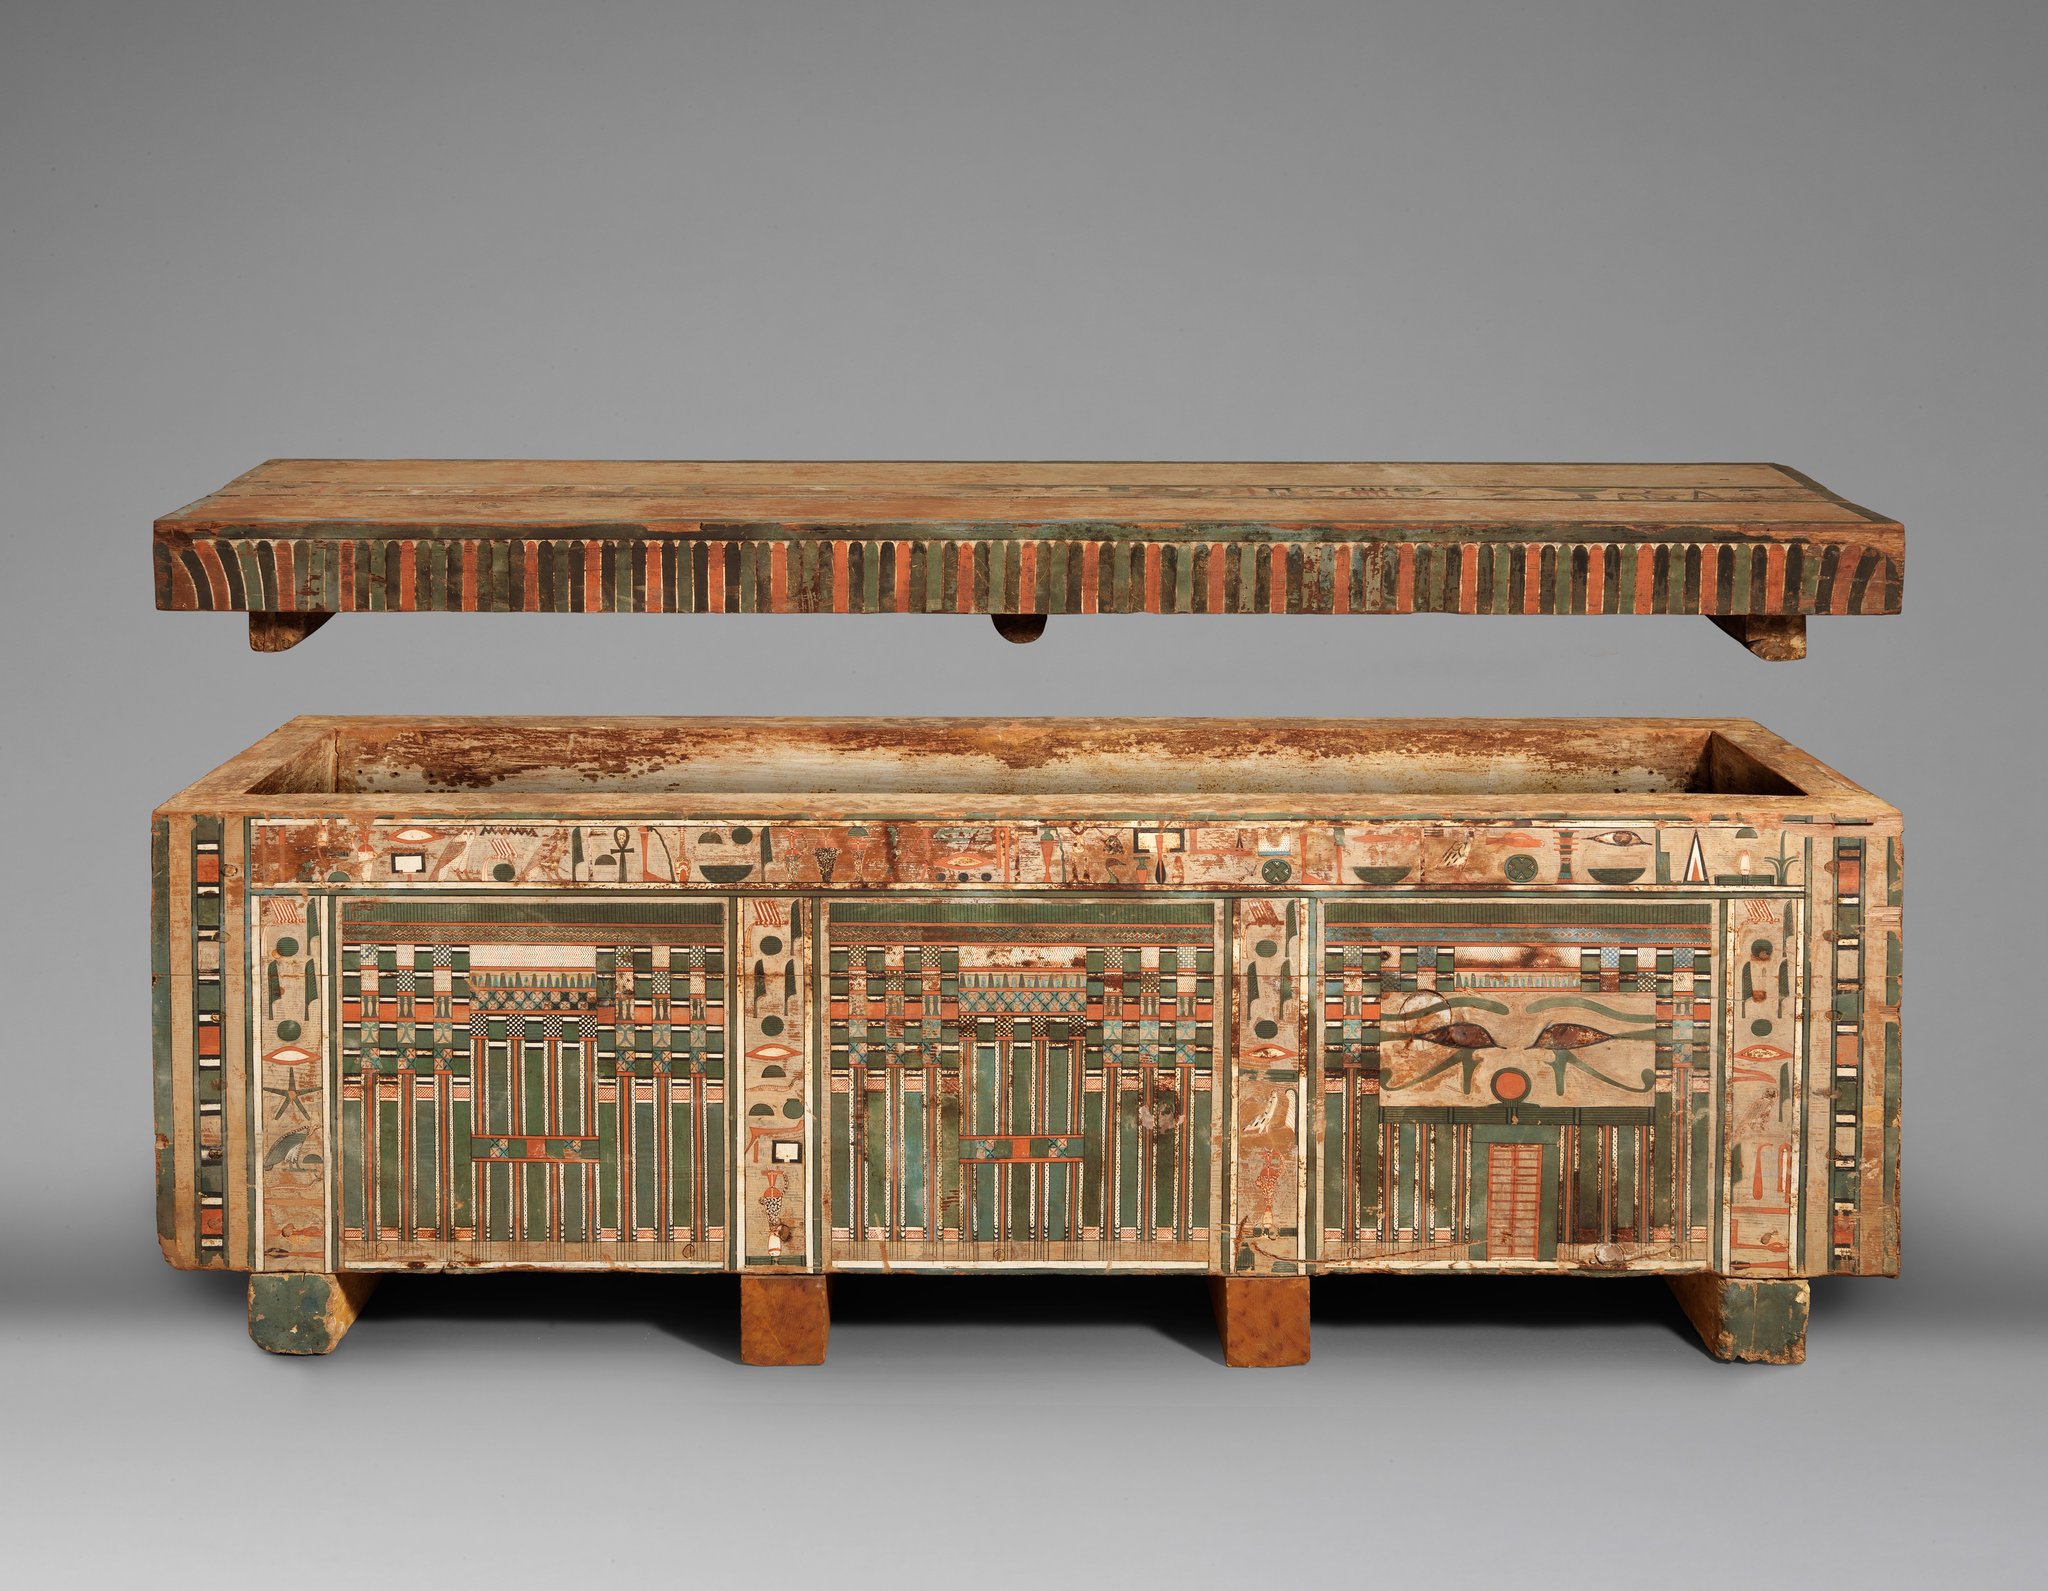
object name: coffin, khnumhotep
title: Coffin of Khnumhotep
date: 1981-1802 BCE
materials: wood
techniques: painting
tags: coffins